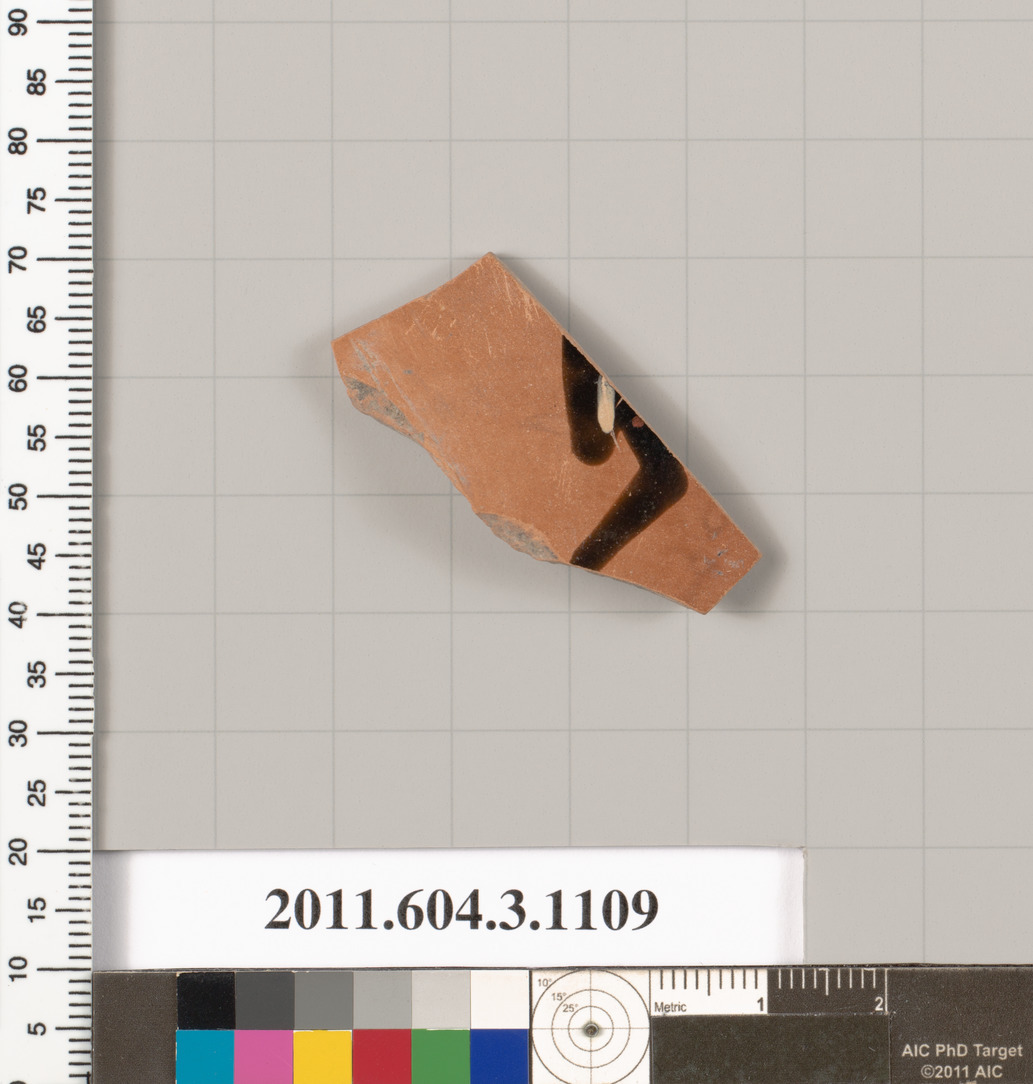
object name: mastoid or kyathos fragment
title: Terracotta fragment of a mastoid (drinking cup with narrow base) or a kyathos (cup-shaped ladle)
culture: greek, attic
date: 534-468 BCE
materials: terracotta